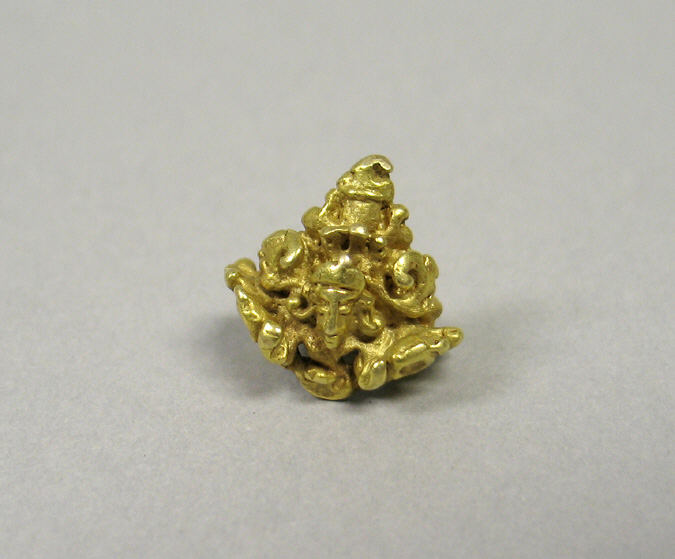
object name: ear ornament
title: Ear Ornament, Garuda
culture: indonesian, central java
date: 701-1200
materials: gold